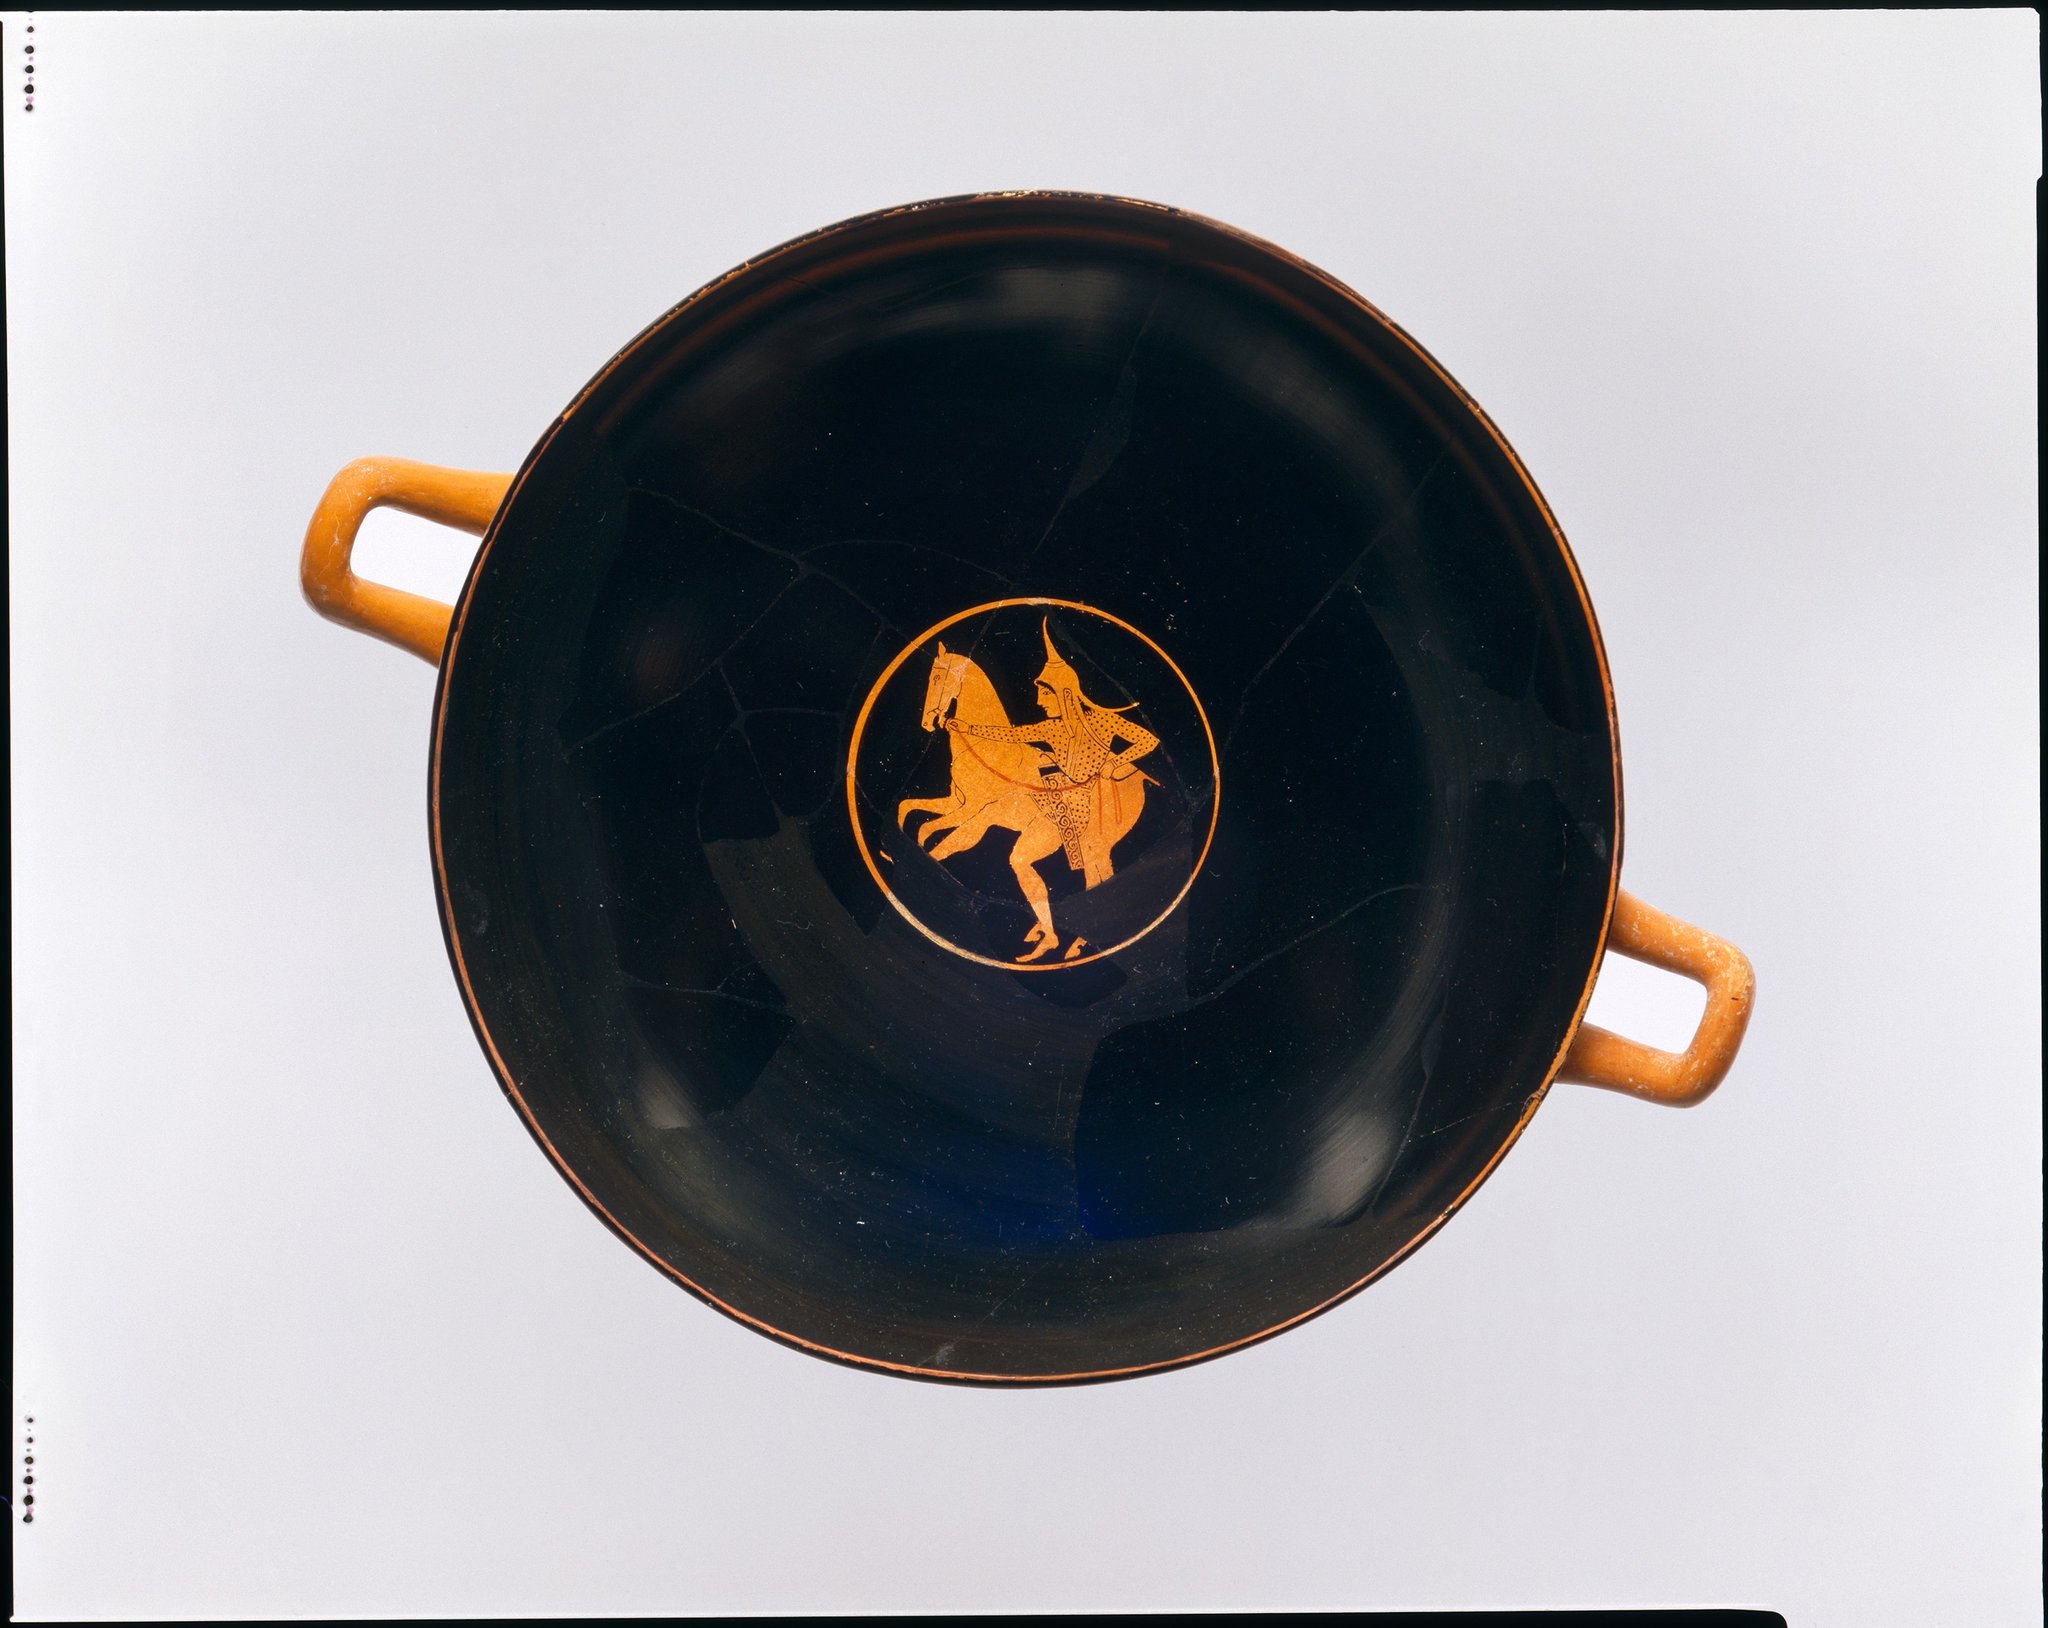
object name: kylix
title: Terracotta kylix (drinking cup)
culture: greek, attic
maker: psiax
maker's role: artist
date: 515 BCE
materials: terracotta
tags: shields,men,horses